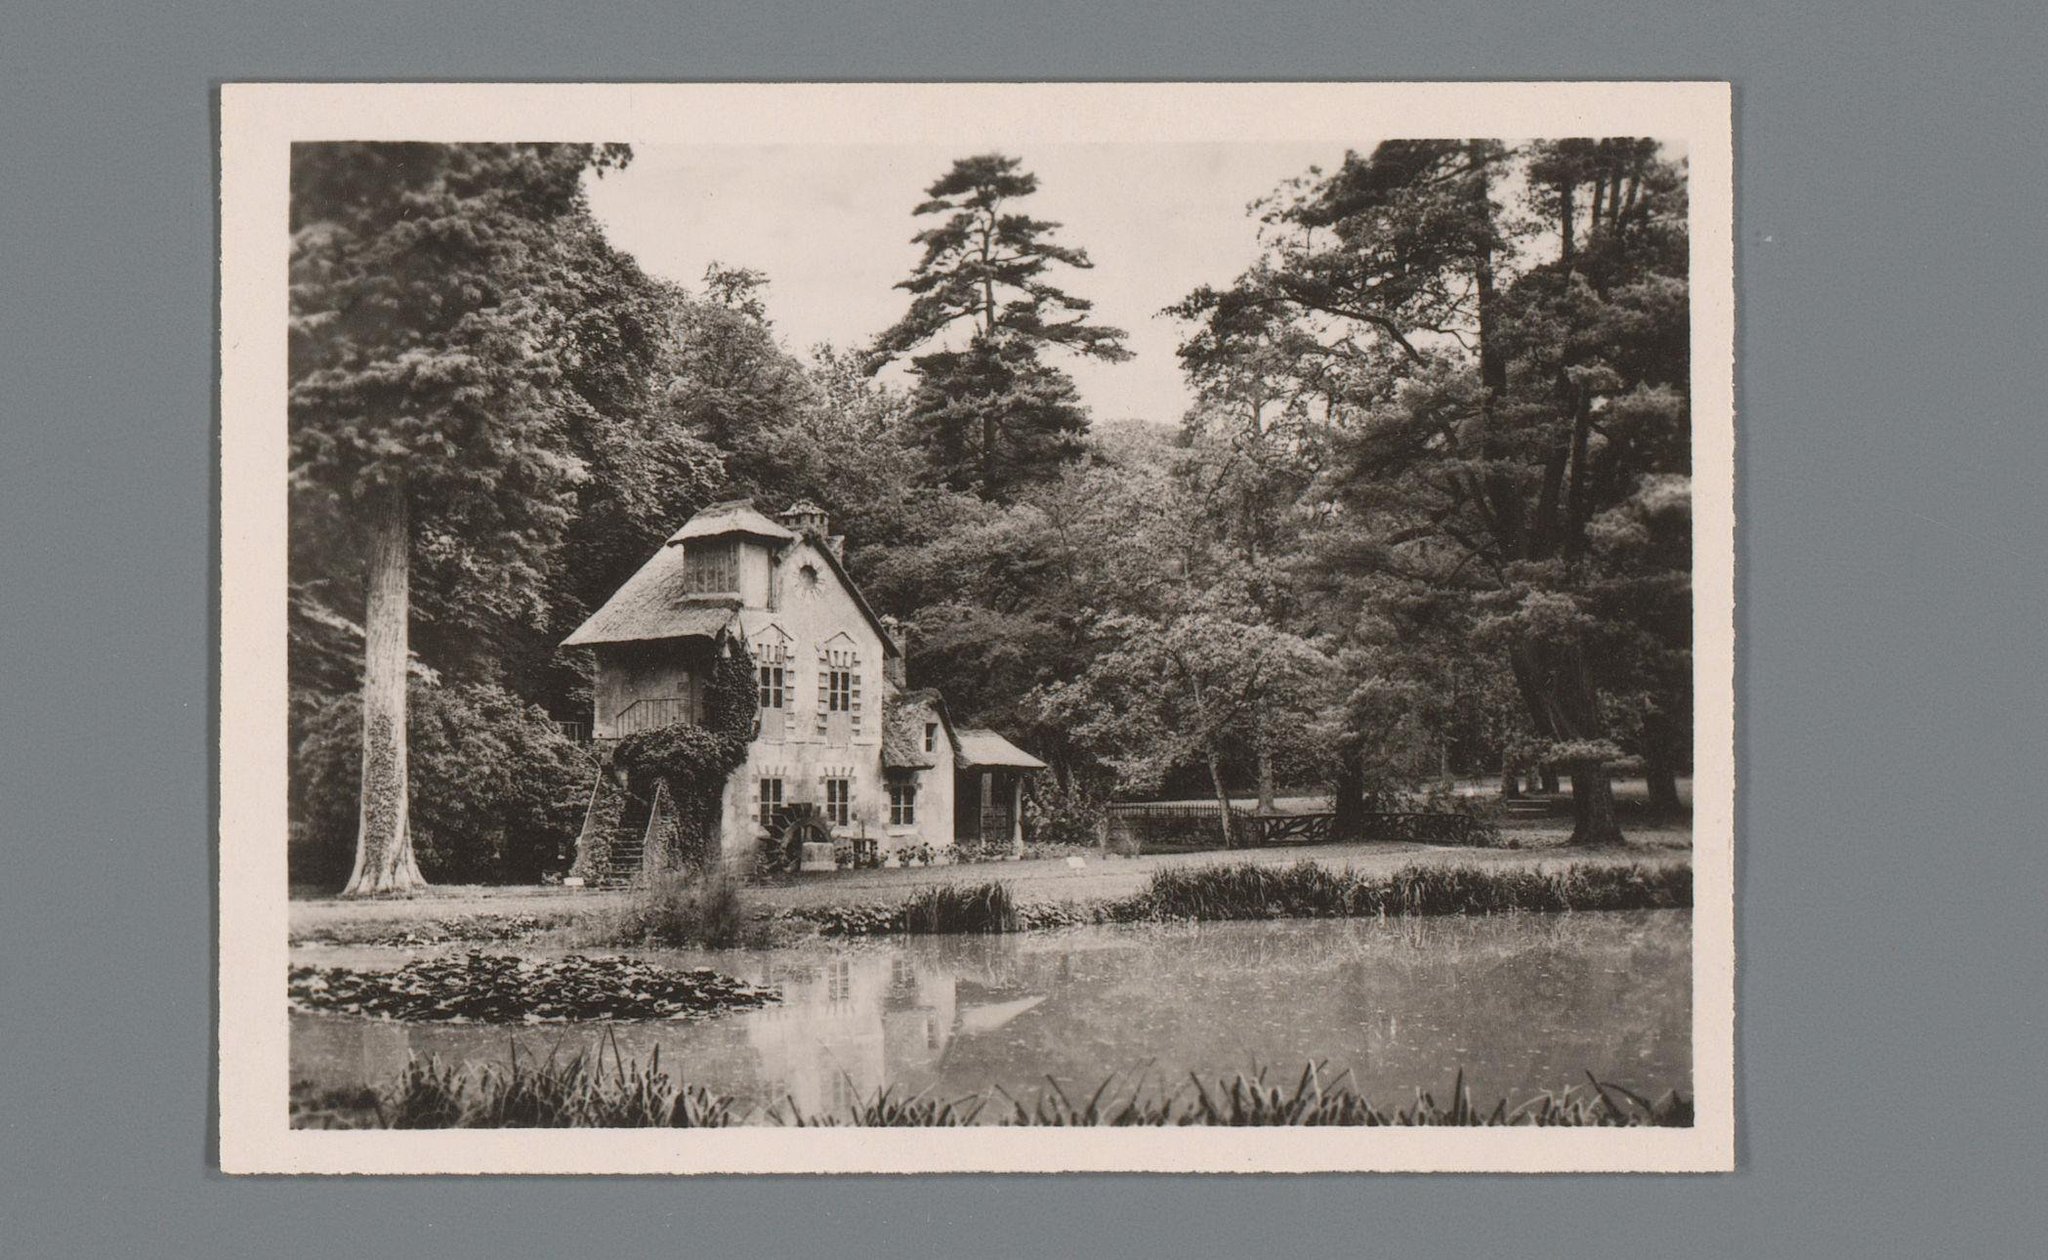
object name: photograph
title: Hameau de Trianon - Le Moulin / The Hamlet of Trianon - The Mill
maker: Anonymous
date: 1900-1920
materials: paper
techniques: gelatin silver print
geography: versailles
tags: watermill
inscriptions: number: ‘18’